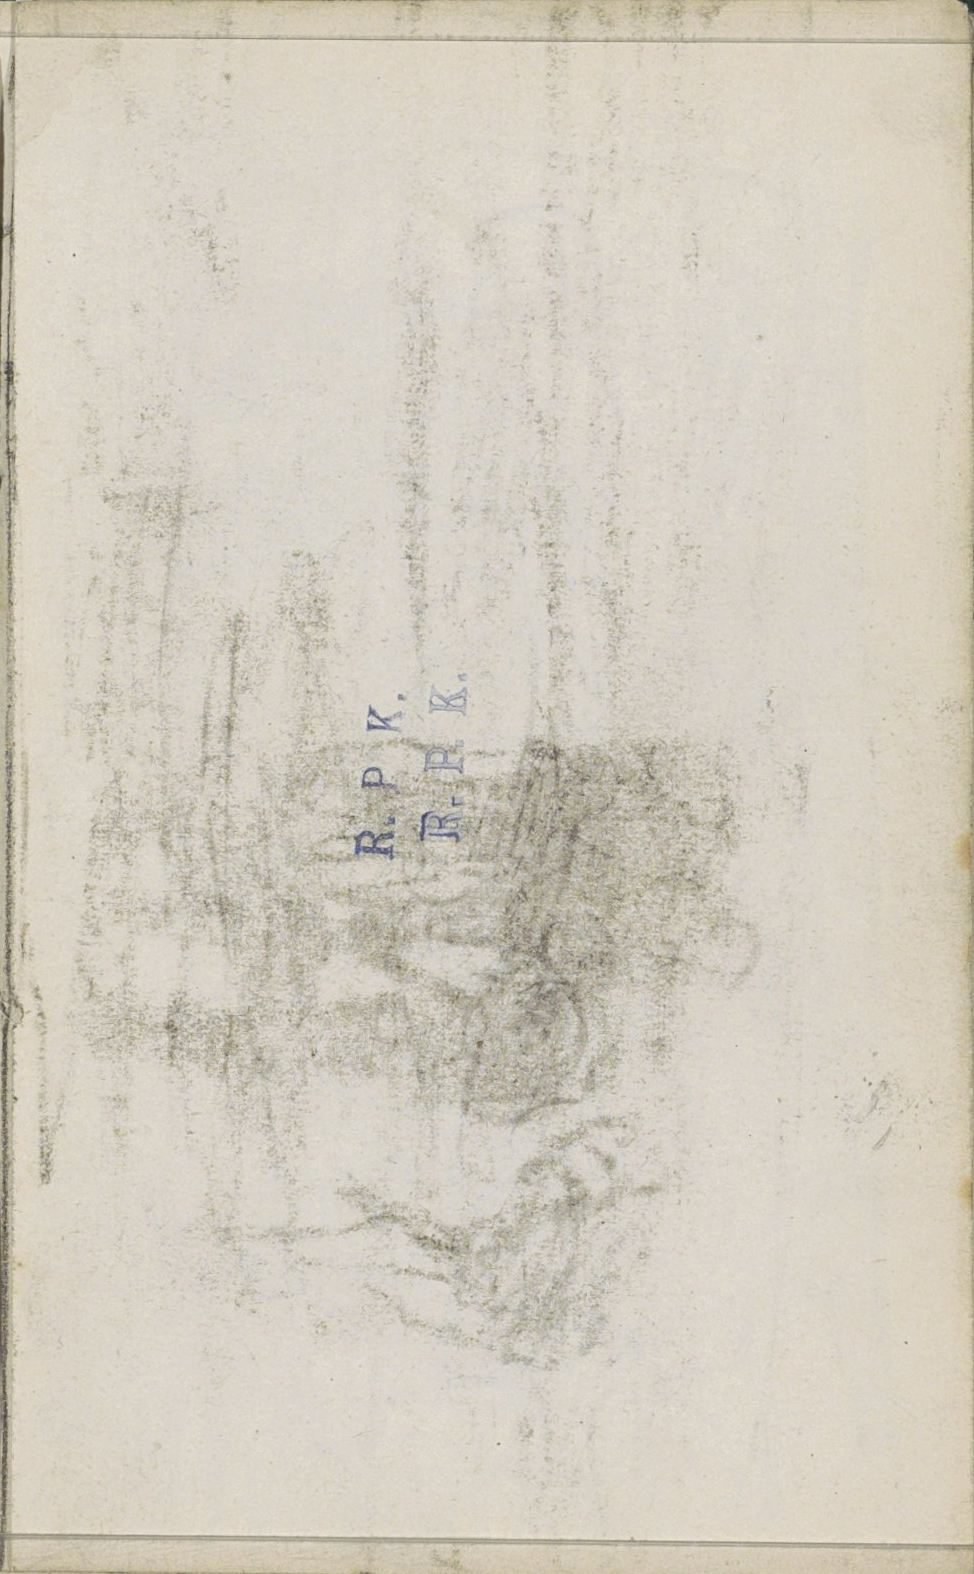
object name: sketchbook leaf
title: Abklatsch van een krijttekening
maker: anton mauve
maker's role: draughtsman, painter, print maker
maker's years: 1838-1888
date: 1848-1888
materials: paper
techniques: printmaking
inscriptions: collector's mark: Lugt L.2233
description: De tekening, vermoedelijk van kinderen aan de vloedlijn, is niet langer aanwezig in het schetsboek. Blad 28 recto uit een schetsboek met 53 bladen.